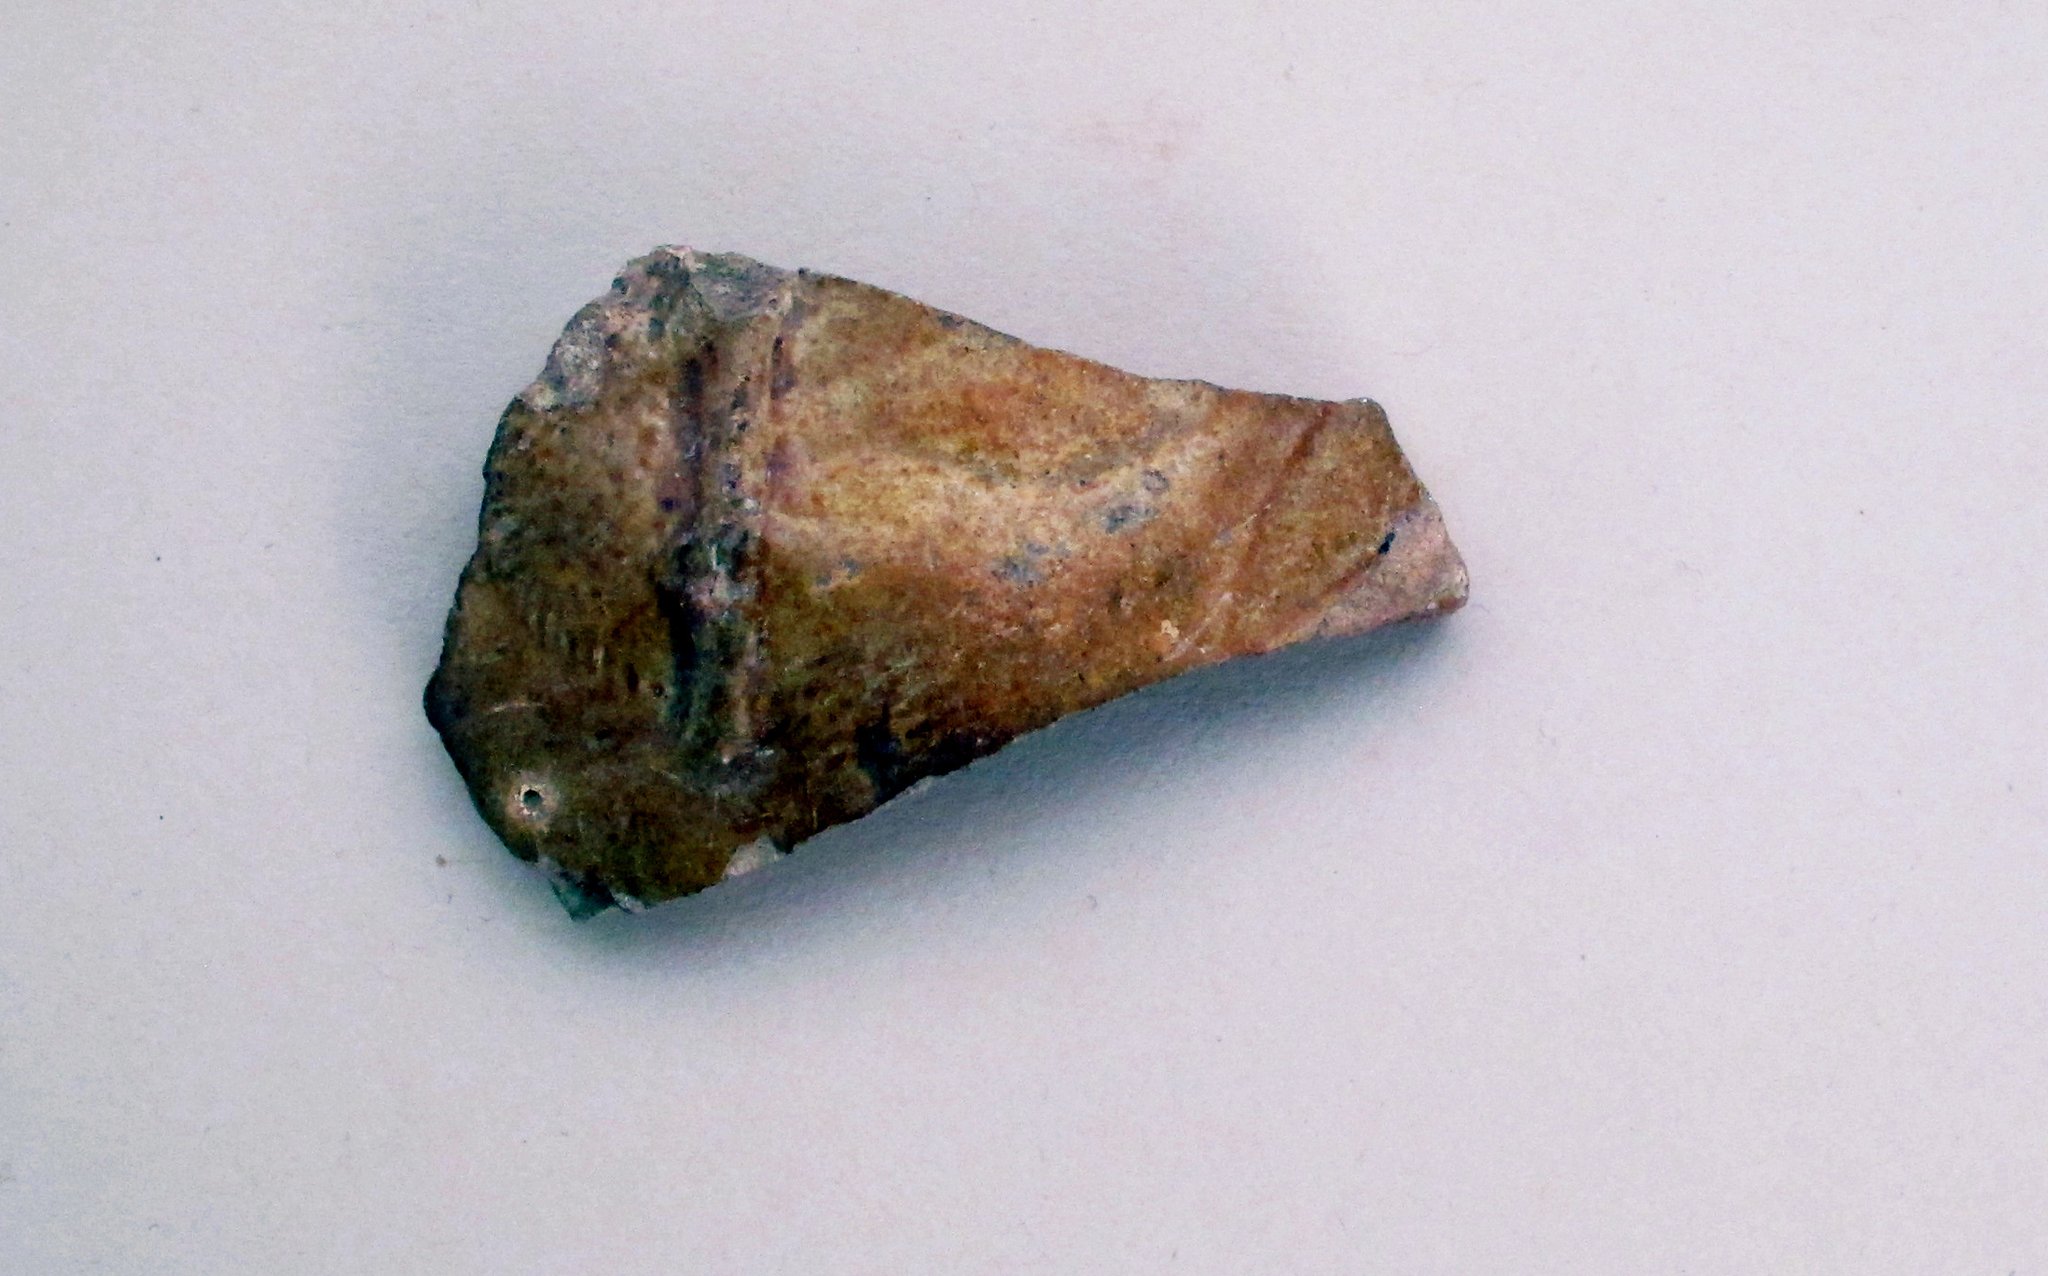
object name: vase fragment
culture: roman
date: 670 BCE-330 CE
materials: terracotta